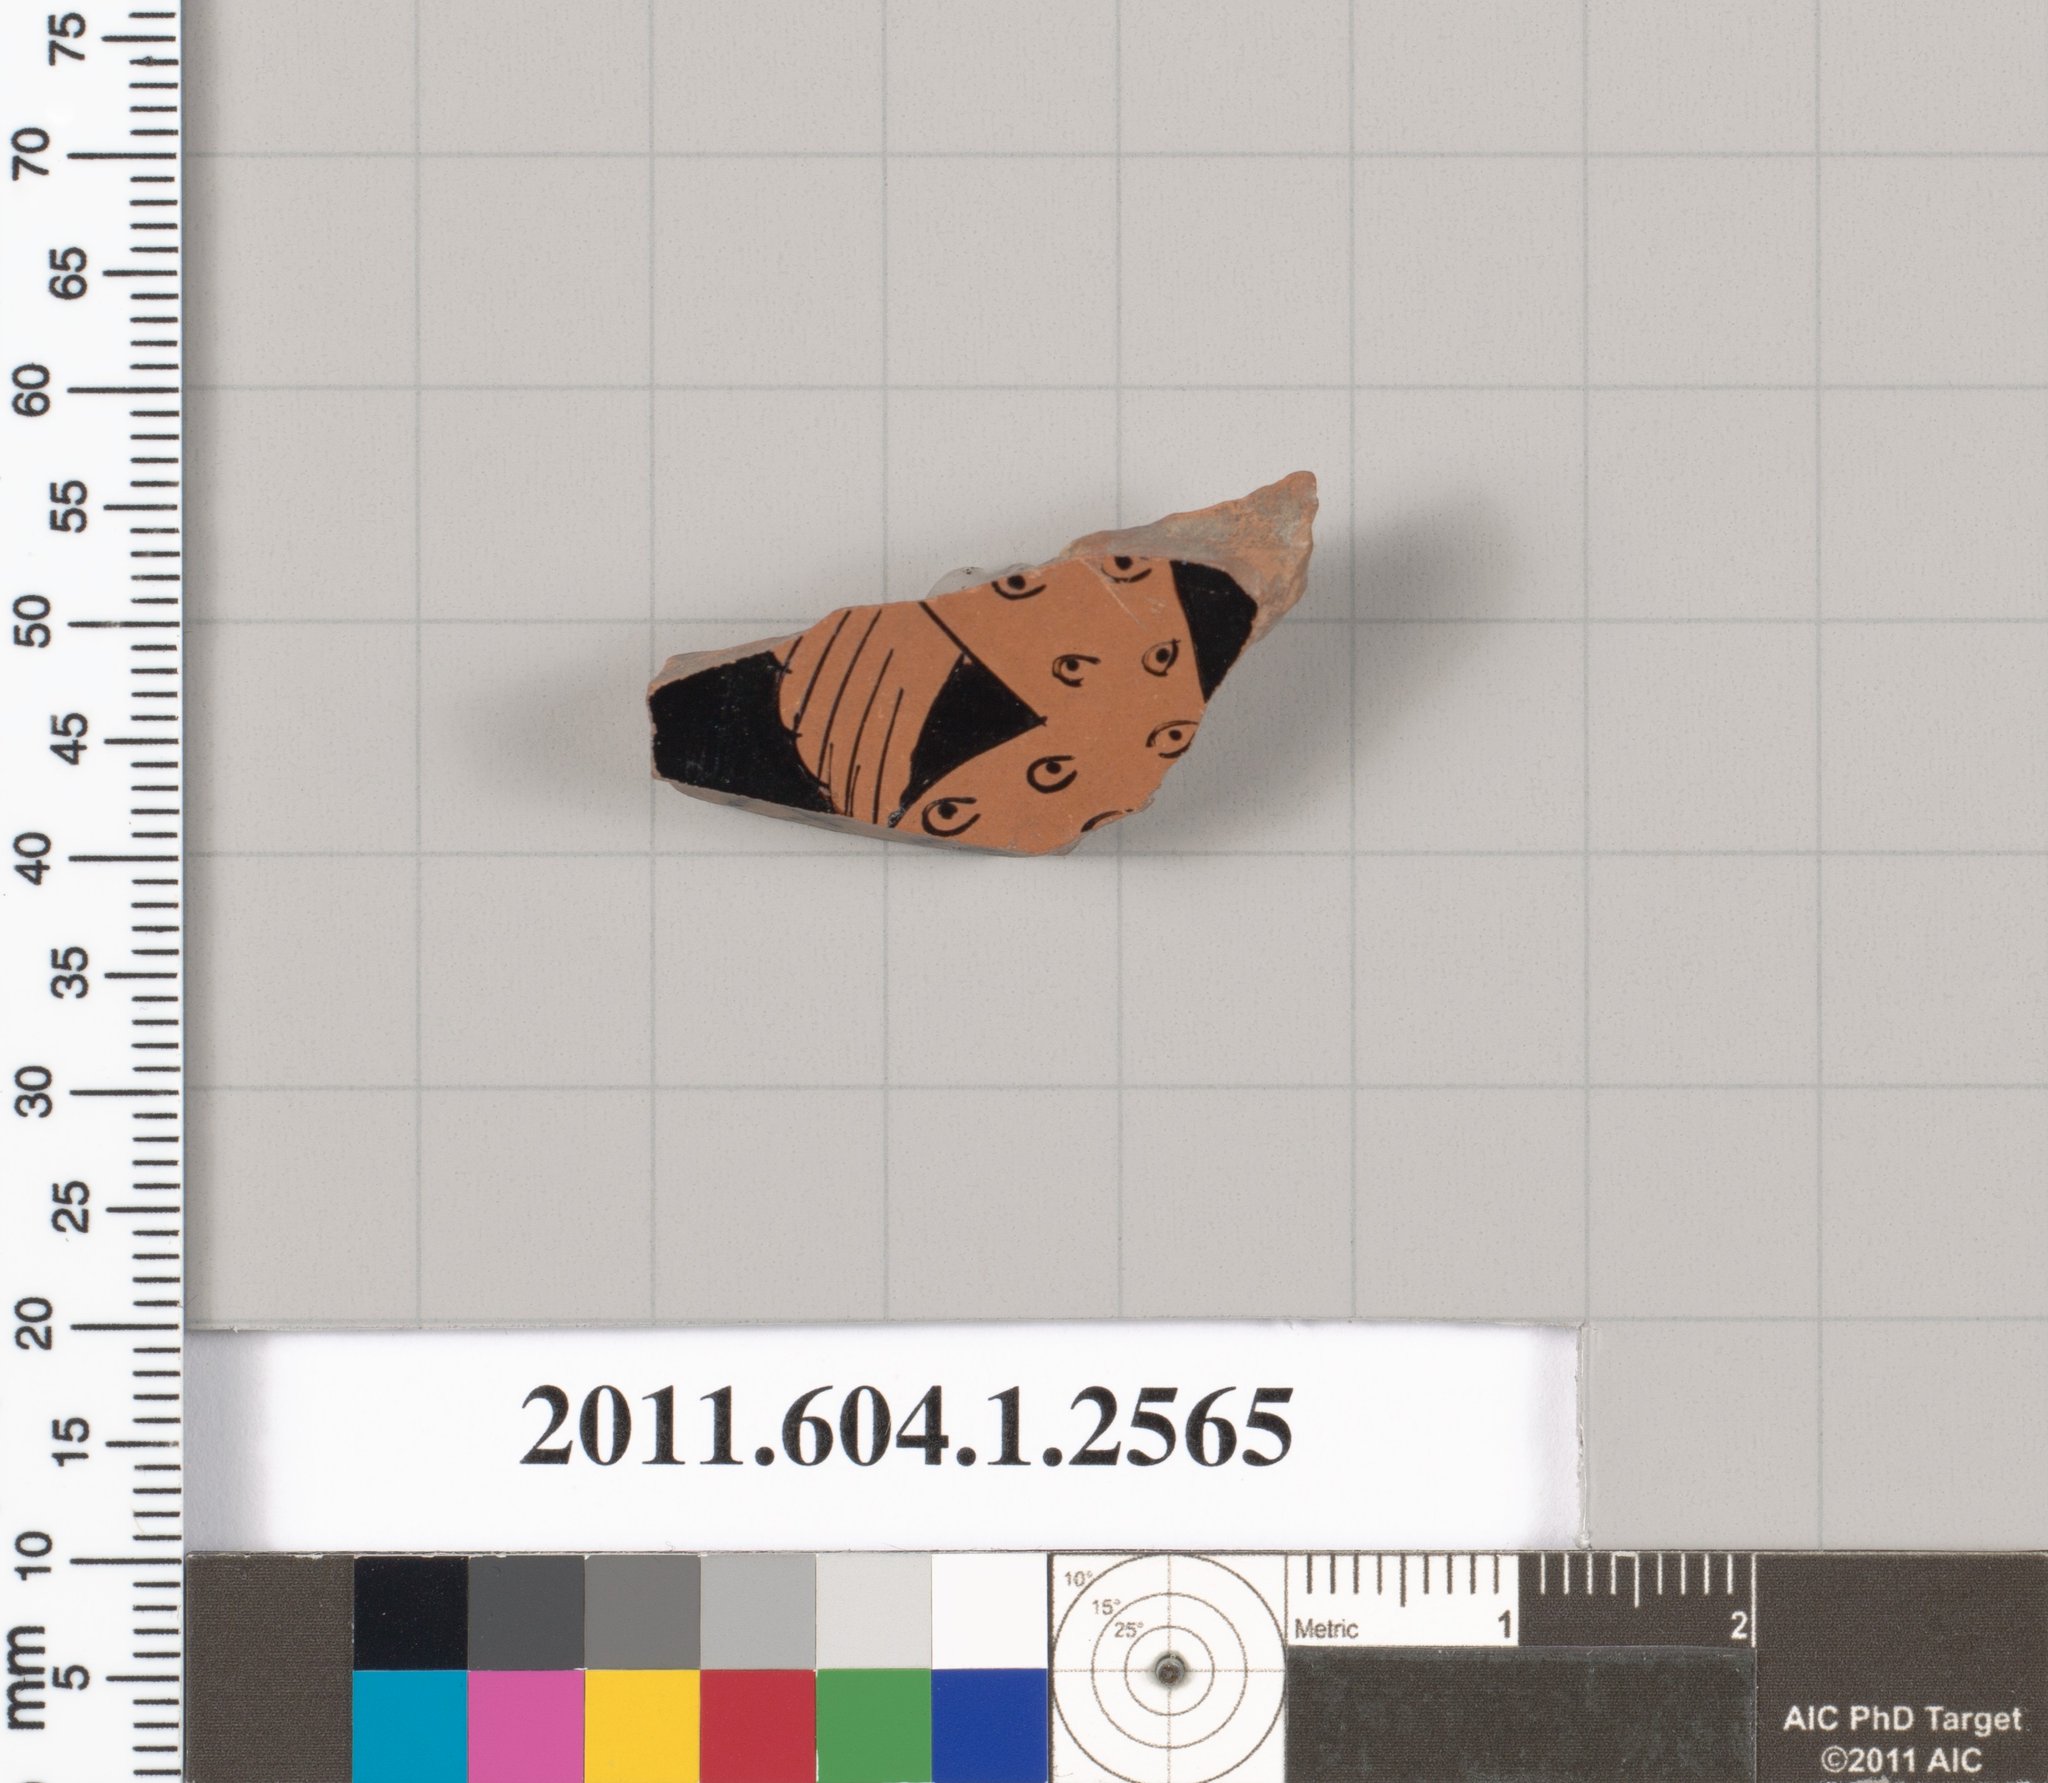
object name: kylix fragment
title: Terracotta fragment of a kylix (drinking cup)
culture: greek, attic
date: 475-451 BCE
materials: terracotta